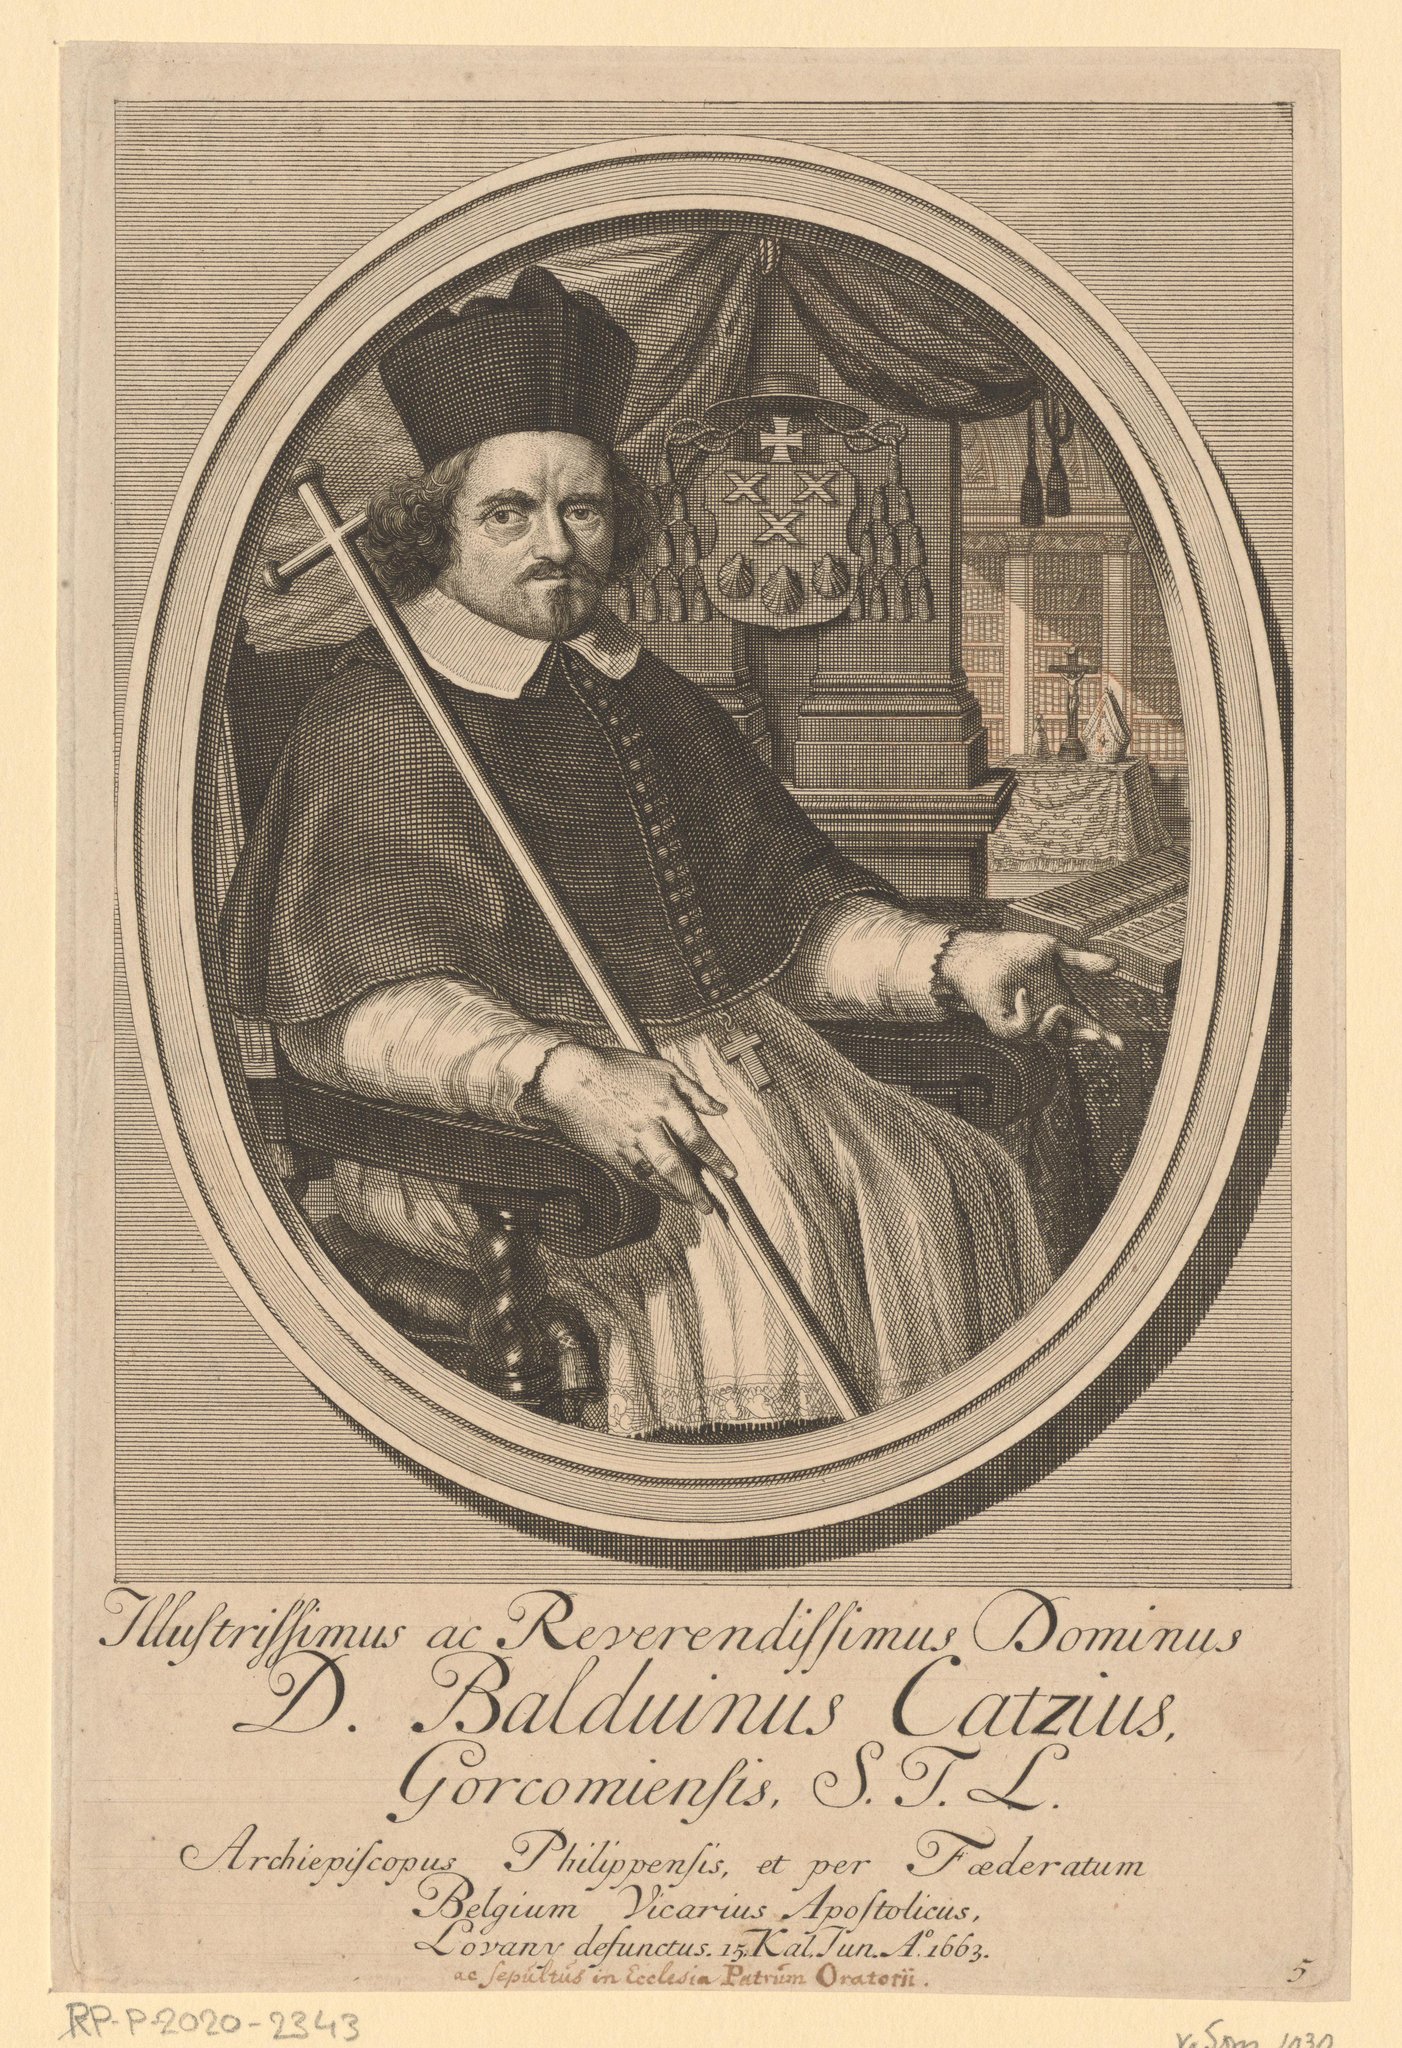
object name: print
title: Portret van Balduinus Cats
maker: françois van bleyswijck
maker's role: draughtsman, print maker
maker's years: 1671-1746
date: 1726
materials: chalk, paper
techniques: engraving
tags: historical persons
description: Prent mogelijk uit: Mieris, Frans van. Kerkelijke Historie en Outheden der Zeven Vereenigde Provincien. Leiden: Dirk Haak, Samuel Luchtmans & Johannes Arnoldus Langerak, 1726.